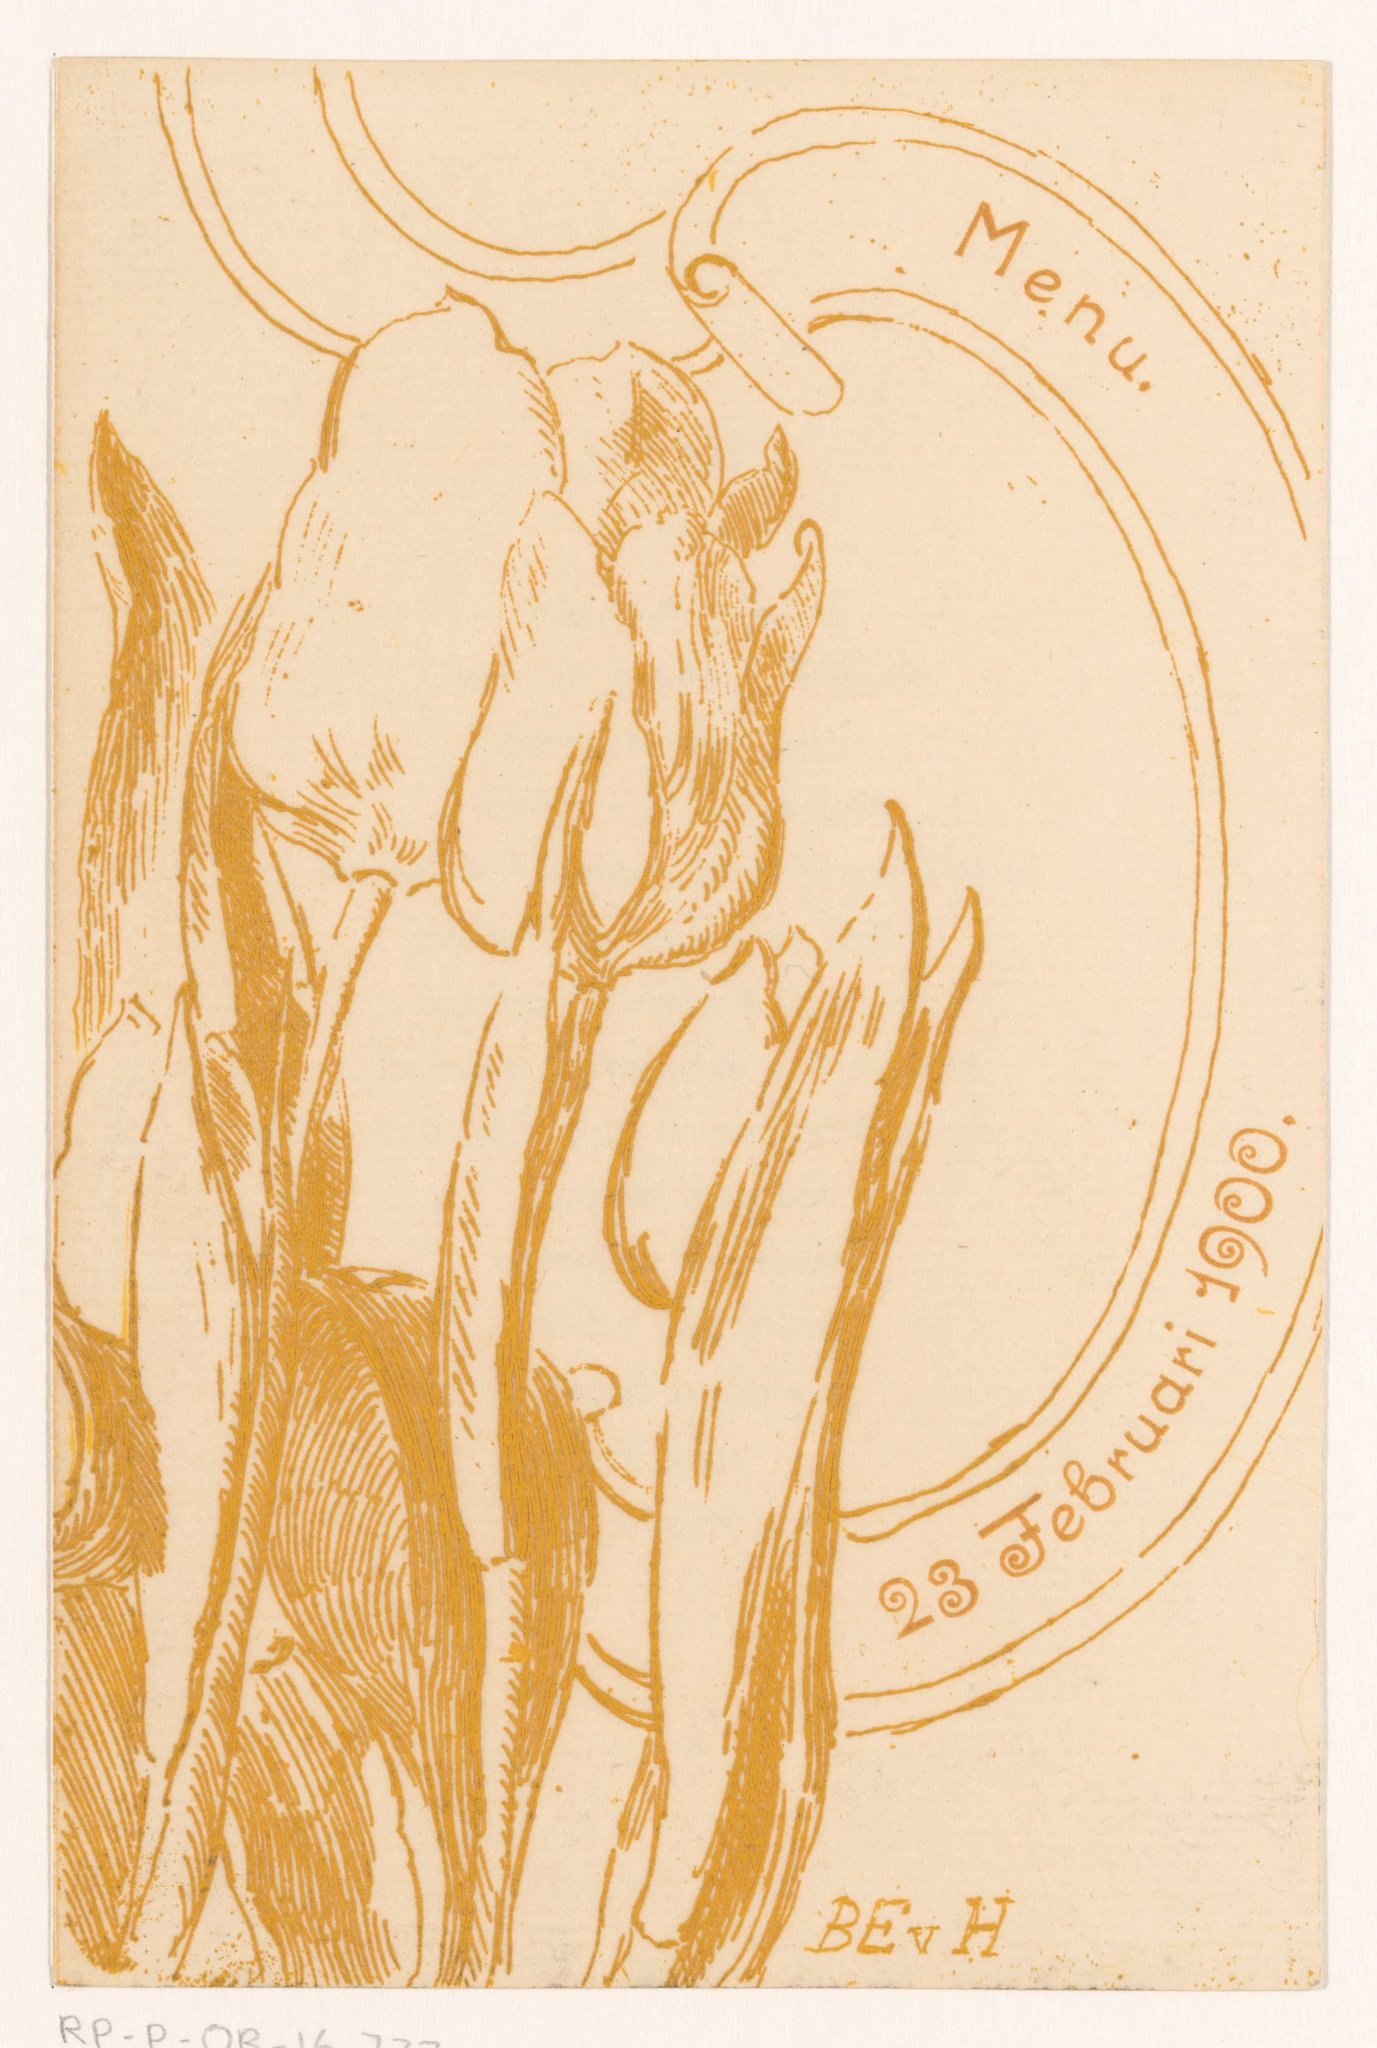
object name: menu, menukaart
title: Menukaart met tulpen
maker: barbara elisabeth van houten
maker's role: draughtsman, print maker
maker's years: 1862-1950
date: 1900-1902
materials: paper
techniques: etching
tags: flowers: tulip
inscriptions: collector's mark: Lugt 2228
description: Links vier tulpen. Rechts een lint met de datum 23 februari 1900.